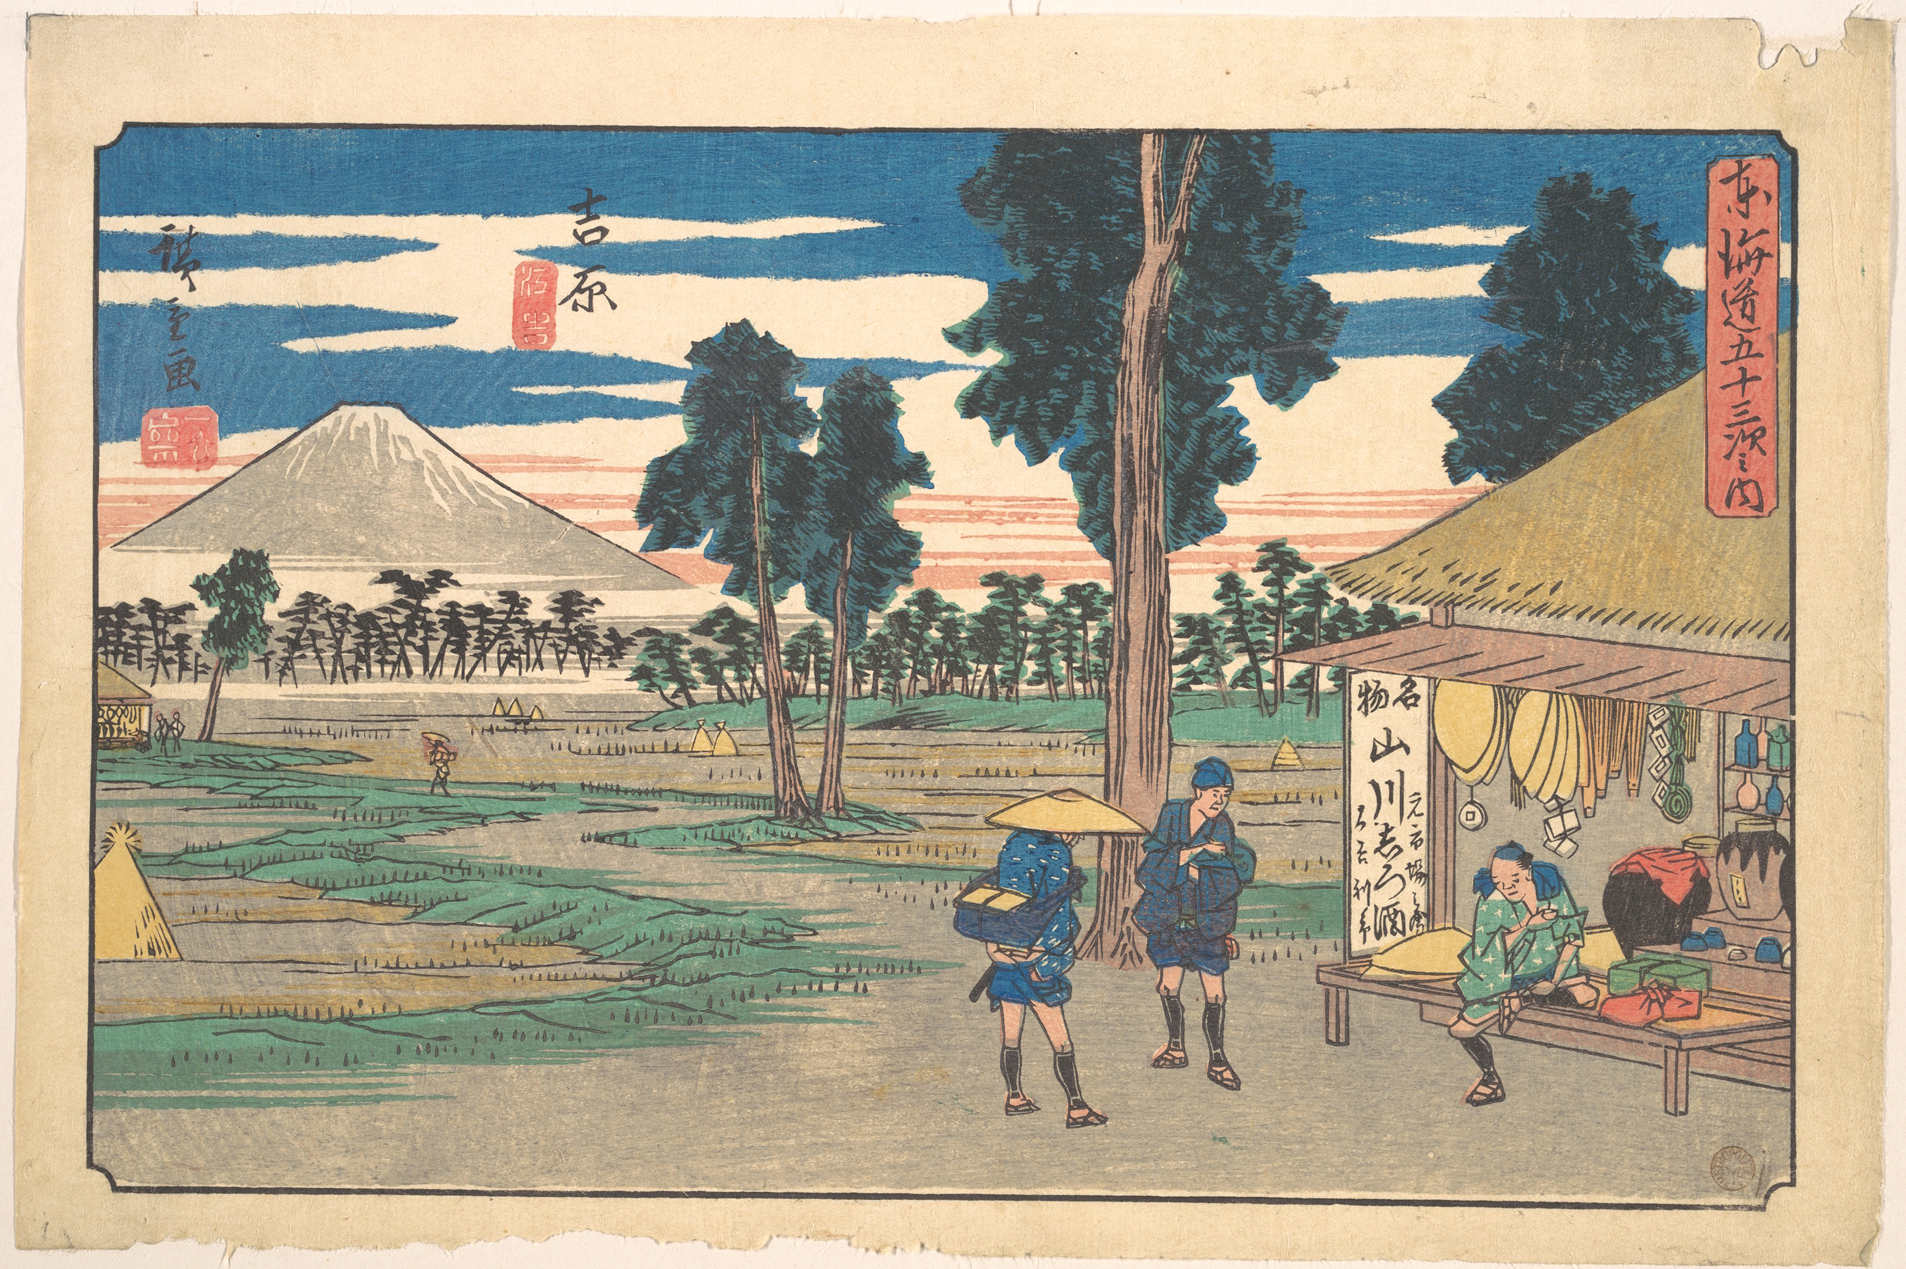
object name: print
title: Yoshiwara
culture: japanese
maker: utagawa hiroshige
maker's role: artist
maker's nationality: japanese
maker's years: 1797-1858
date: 1842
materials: ink, paper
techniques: woodblock print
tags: men,mountains,landscapes,trees